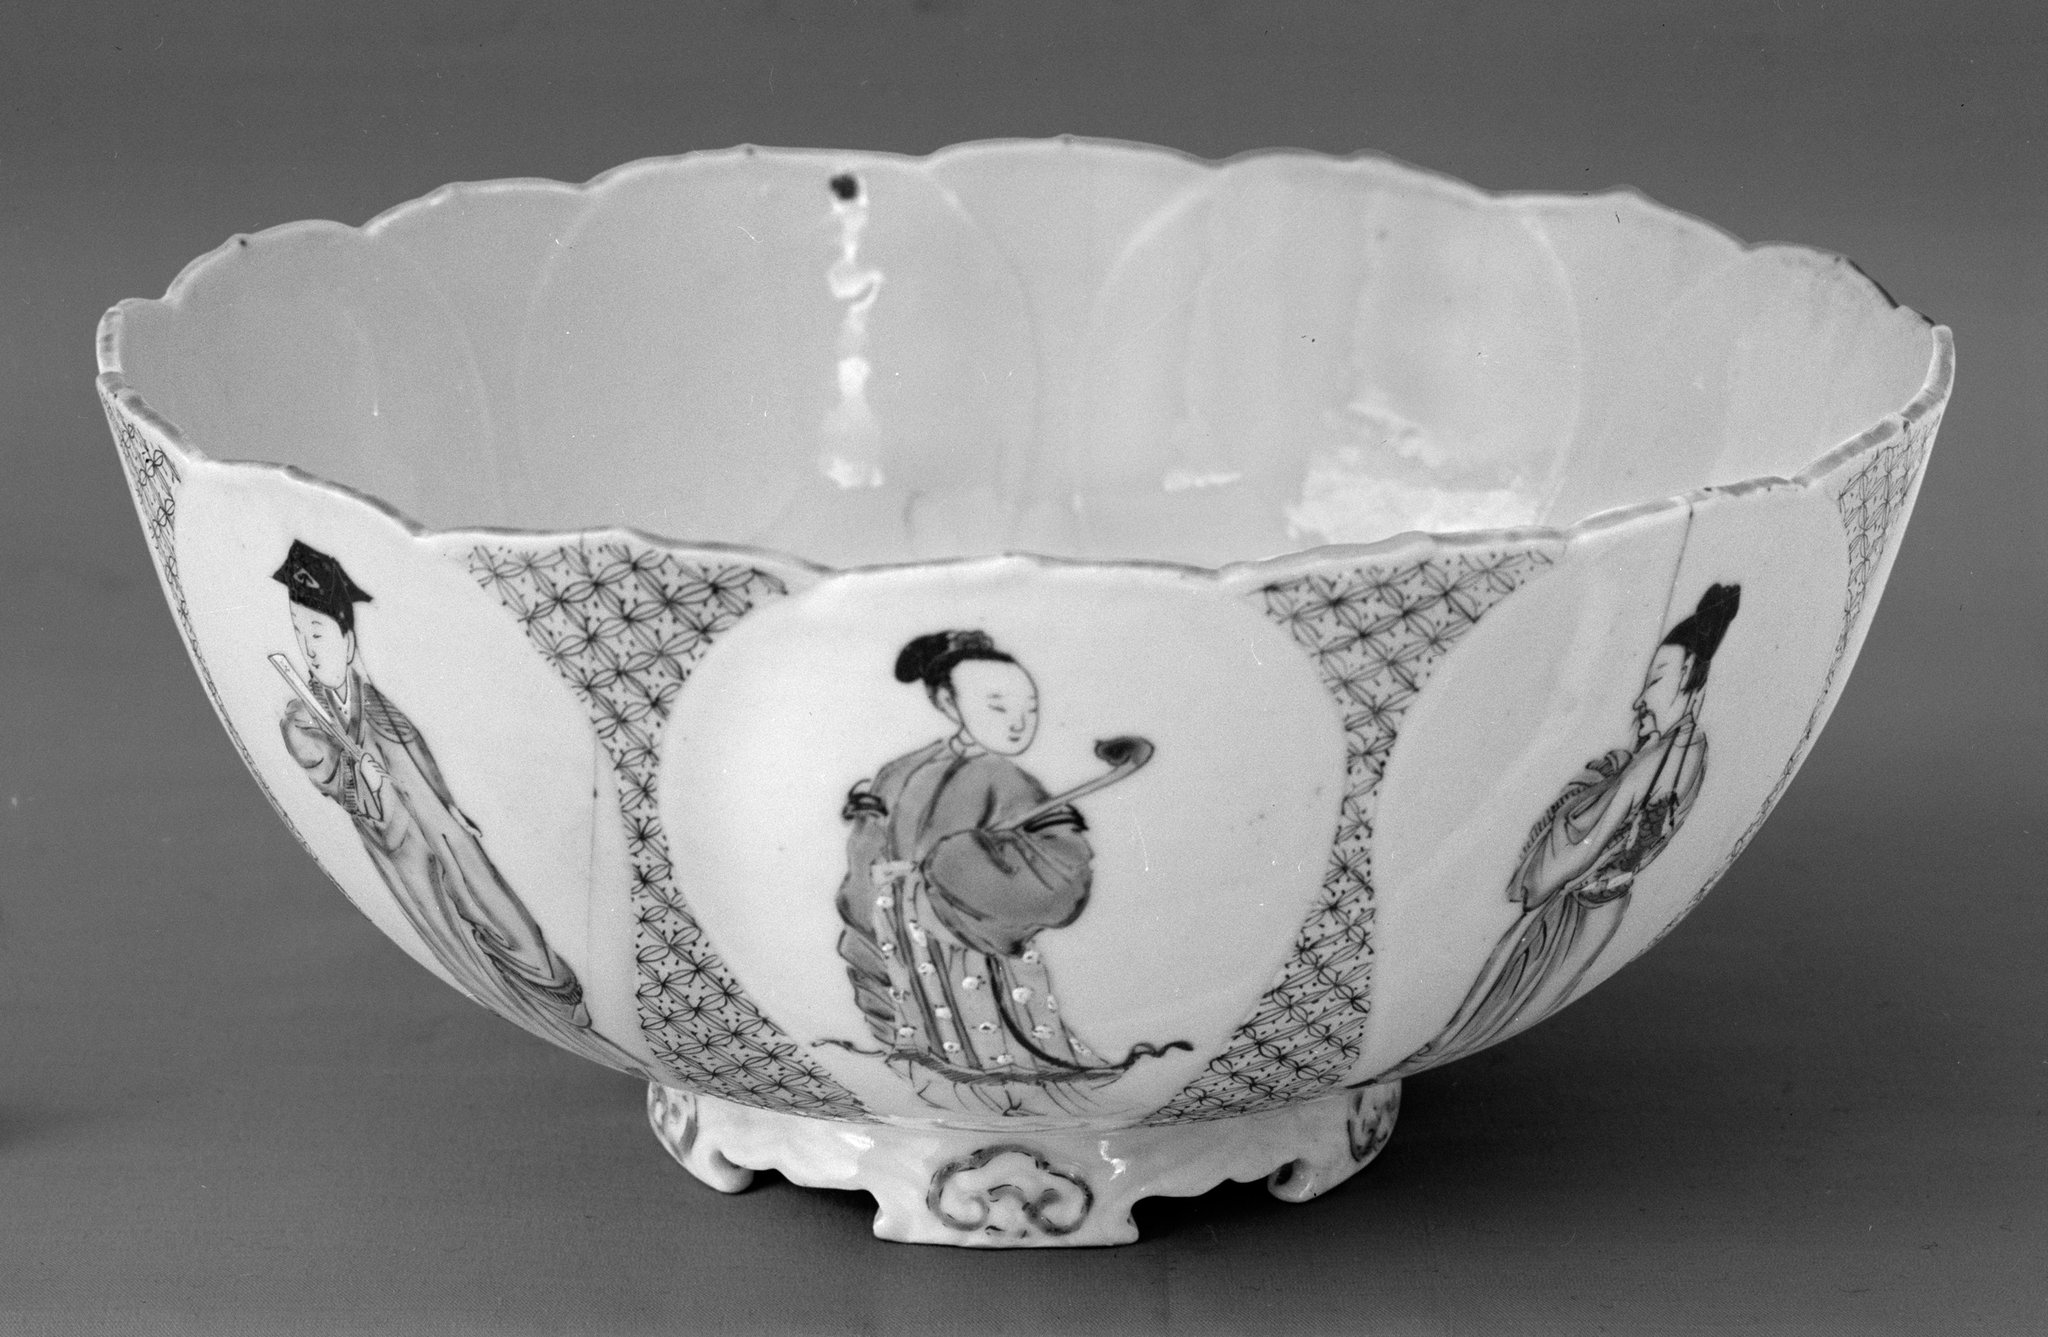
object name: bowl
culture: chinese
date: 1701-1800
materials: enamel, porcelain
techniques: overglaze, painting, polychrome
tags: men,women